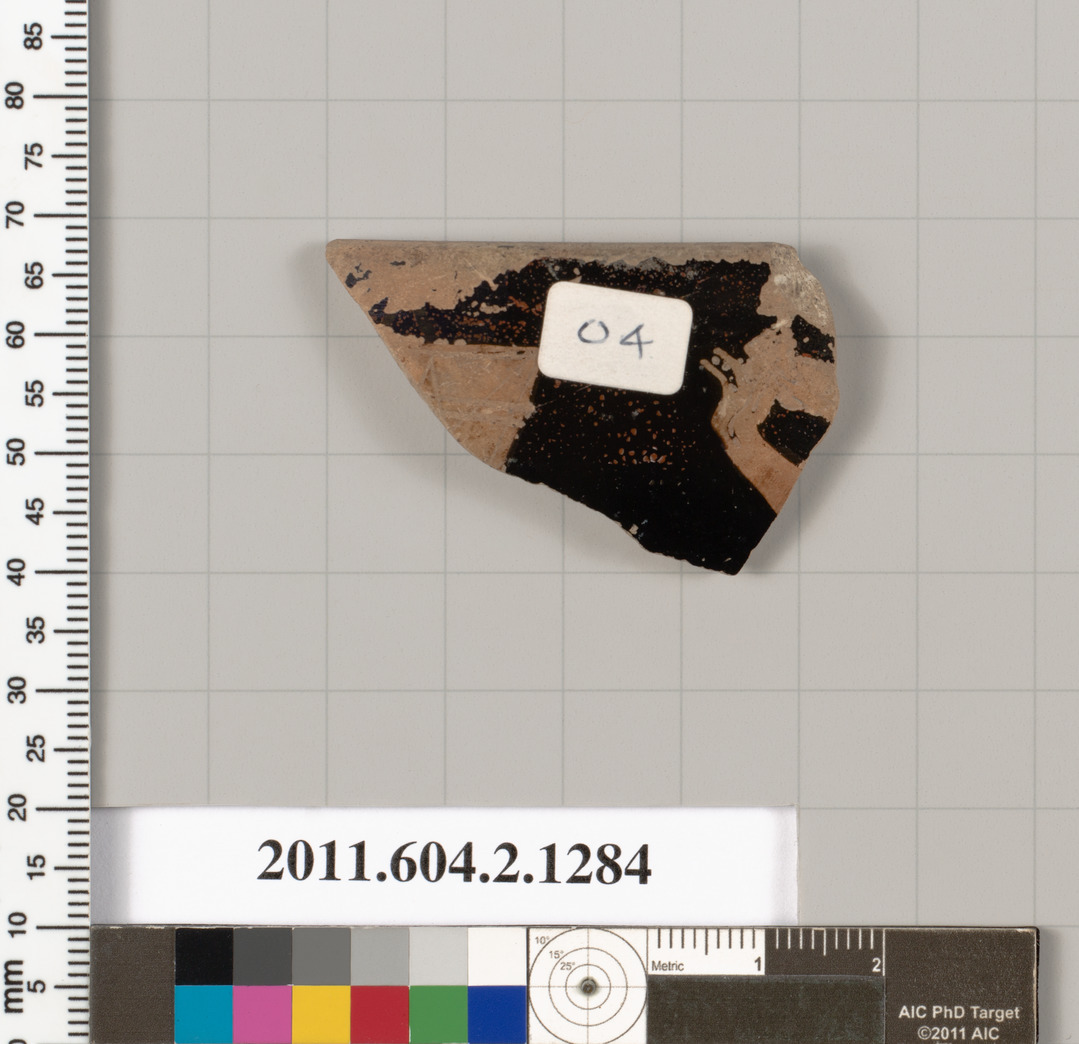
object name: skyphos fragment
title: Terracotta rim fragment of a skyphos (deep drinking cup)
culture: greek, attic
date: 490-480 BCE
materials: terracotta